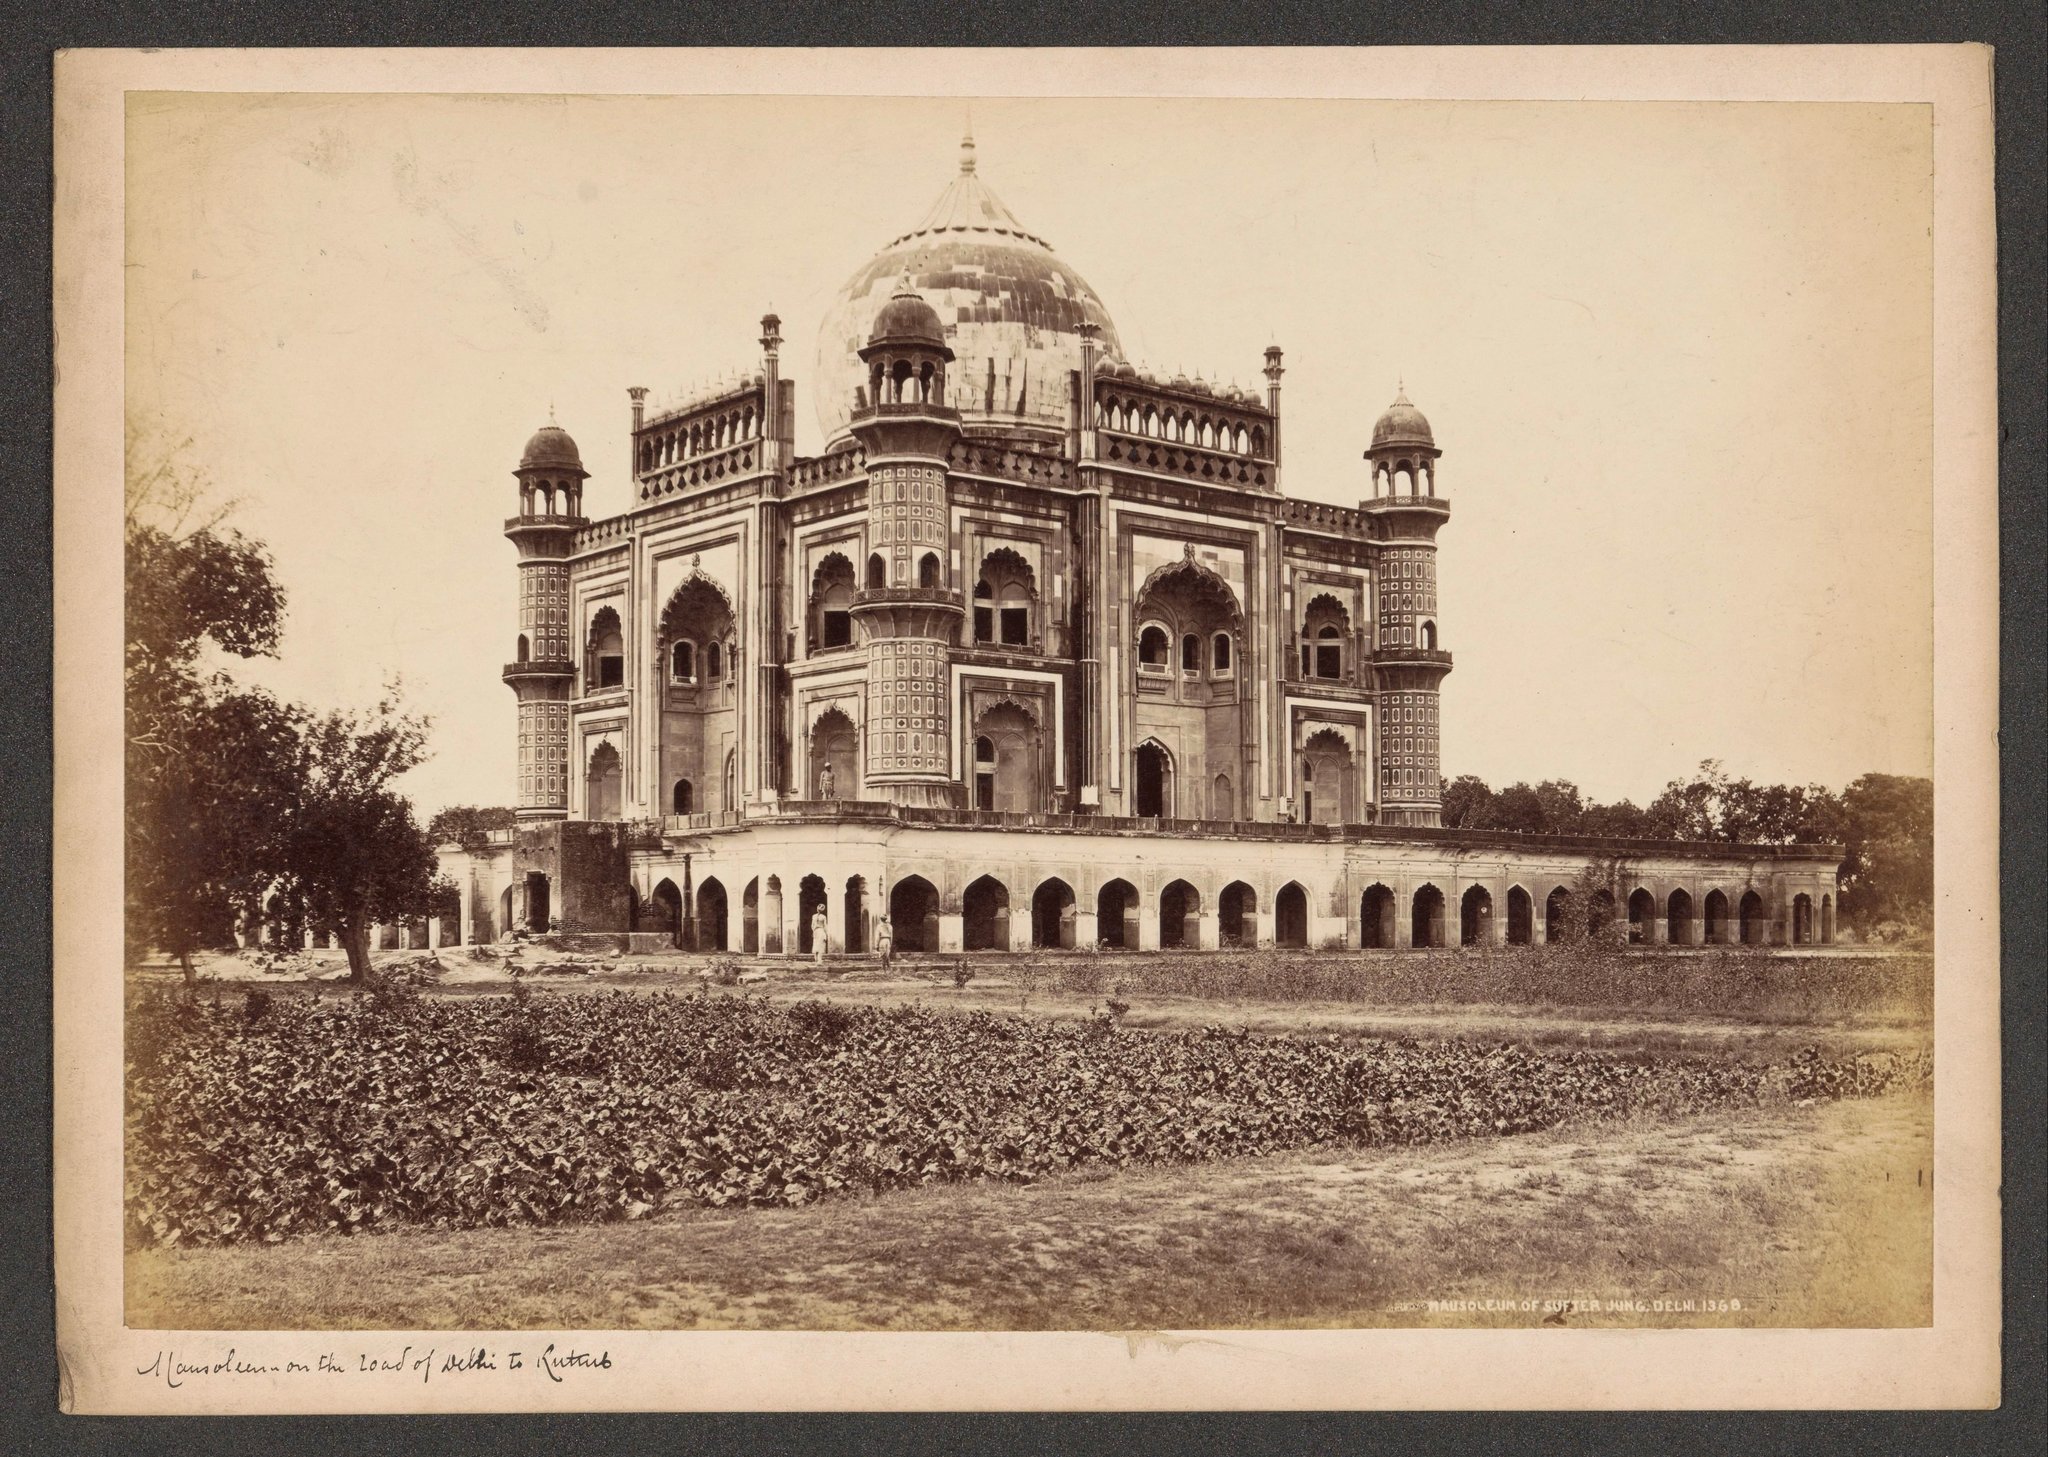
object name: photograph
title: Safdarjung Tomb, Delhi, India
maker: samuel bourne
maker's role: fotograaf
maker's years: 1834-1912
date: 1863-1866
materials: cardboard, paper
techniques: albumen print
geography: delhi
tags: mausoleum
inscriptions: inscription: ‘B & S of Bourne (t)’, number: ‘41’, title: ‘Mausoleum of Sufter Jung. Delhi.’, number: ‘1368’, inscription: ‘Mausoleum on the road of Delhi to Kuttub’